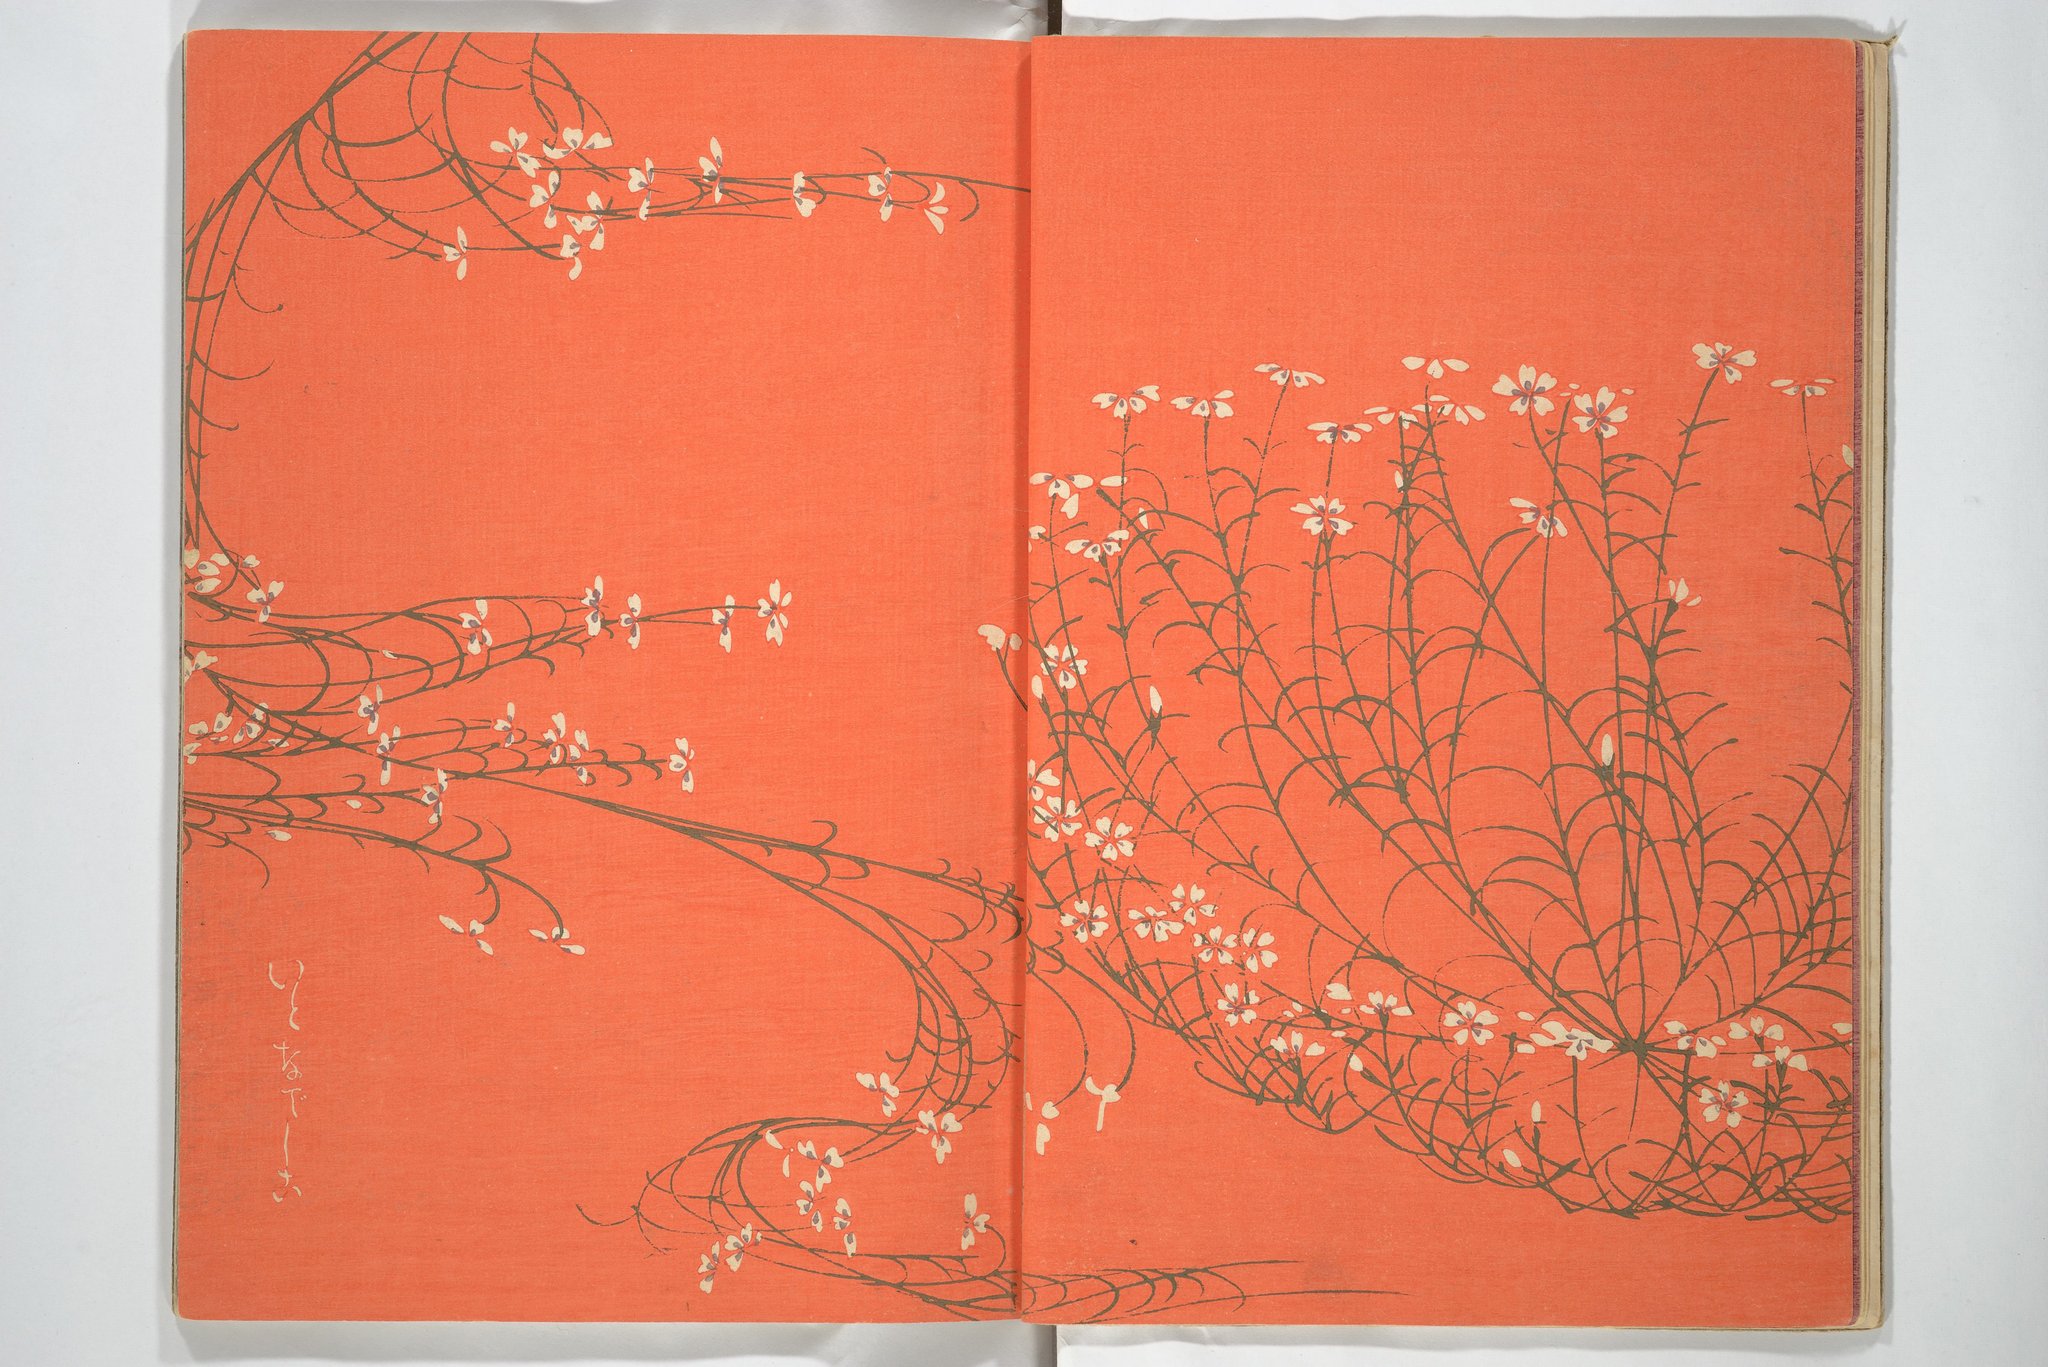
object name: illustrated book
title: Practical Sketchbook (Ōyō manga) 応用漫画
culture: japanese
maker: ogino issui 荻野一水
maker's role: artist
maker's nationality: japanese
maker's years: 1900-1910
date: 1903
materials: ink, paper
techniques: woodblock print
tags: flowers